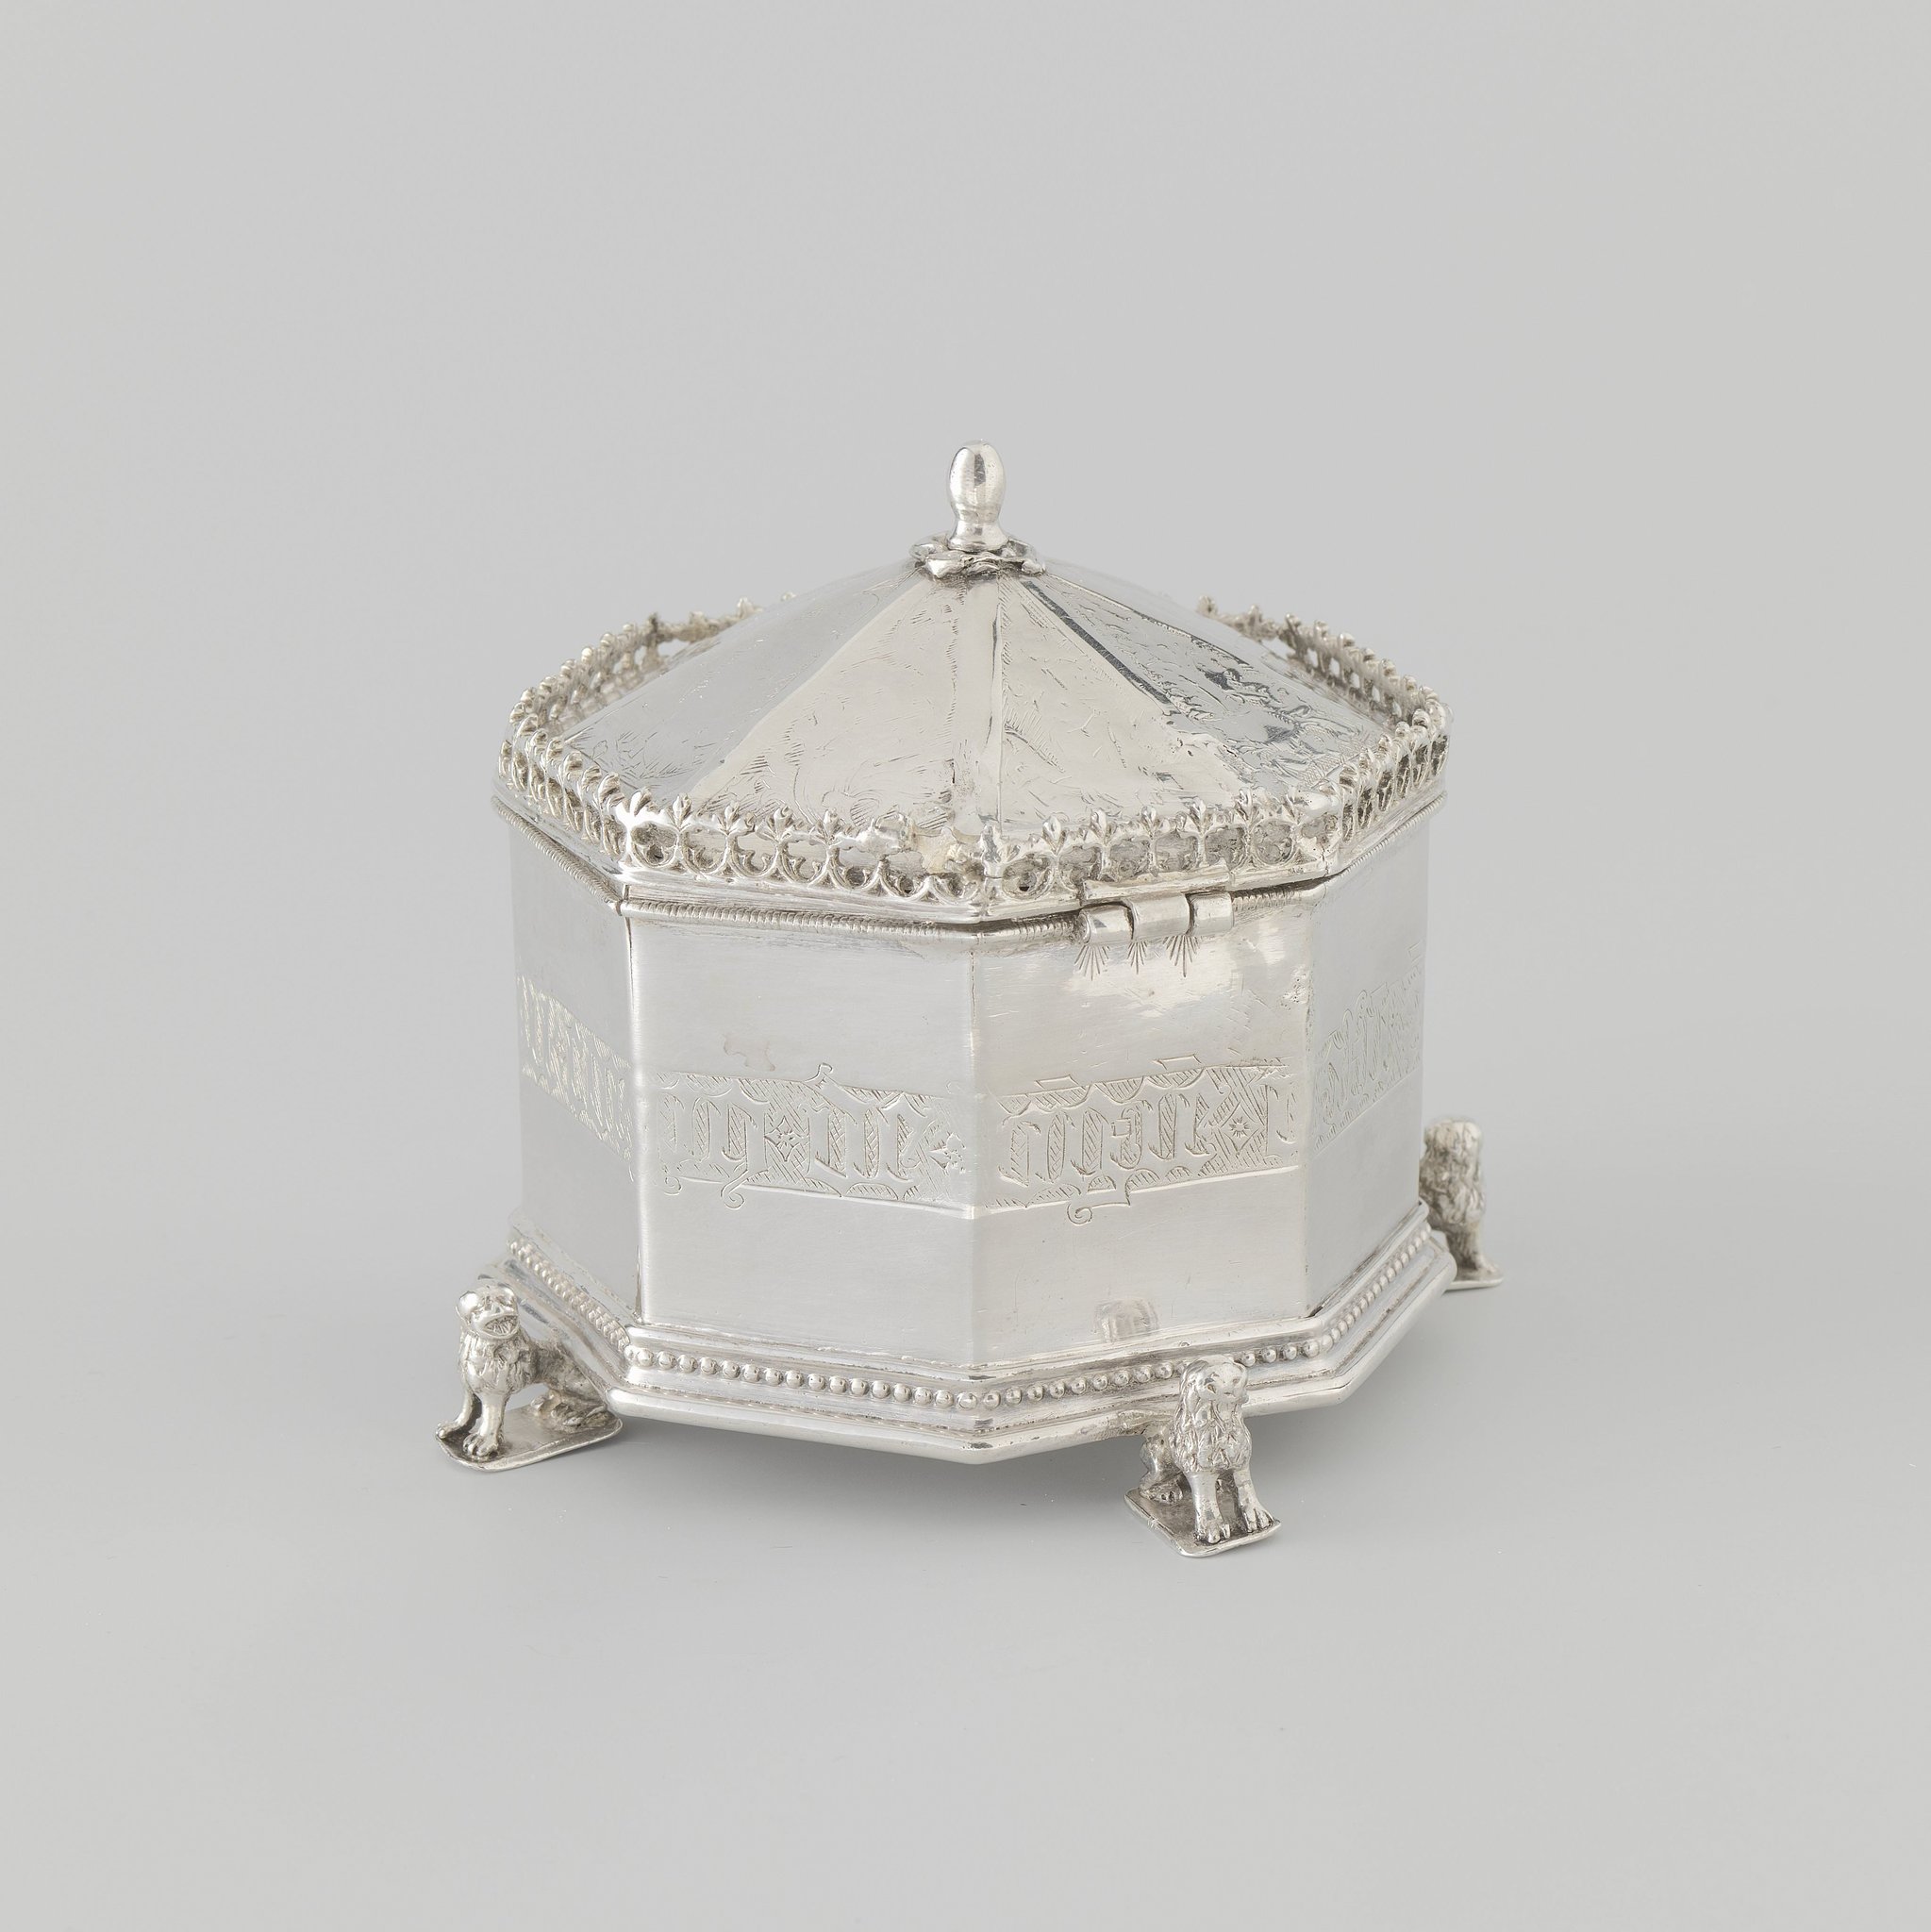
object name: pyx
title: Communion host container or pyx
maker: Anonymous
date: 1495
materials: silver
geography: the hague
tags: beasts of prey, predatory animals: lion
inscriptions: inscription: ‘Hic est servatum corpus de virgine natum. Anno MCCCCXCV’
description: The Latin inscription on this pyx from The Hague reads as follows: ‘De virgine natum anno MCDXCV’ (Born of the Virgin, from the year 1495). This is a reference to the host, the symbolic body of Christ, who was born of the Virgin Mary.